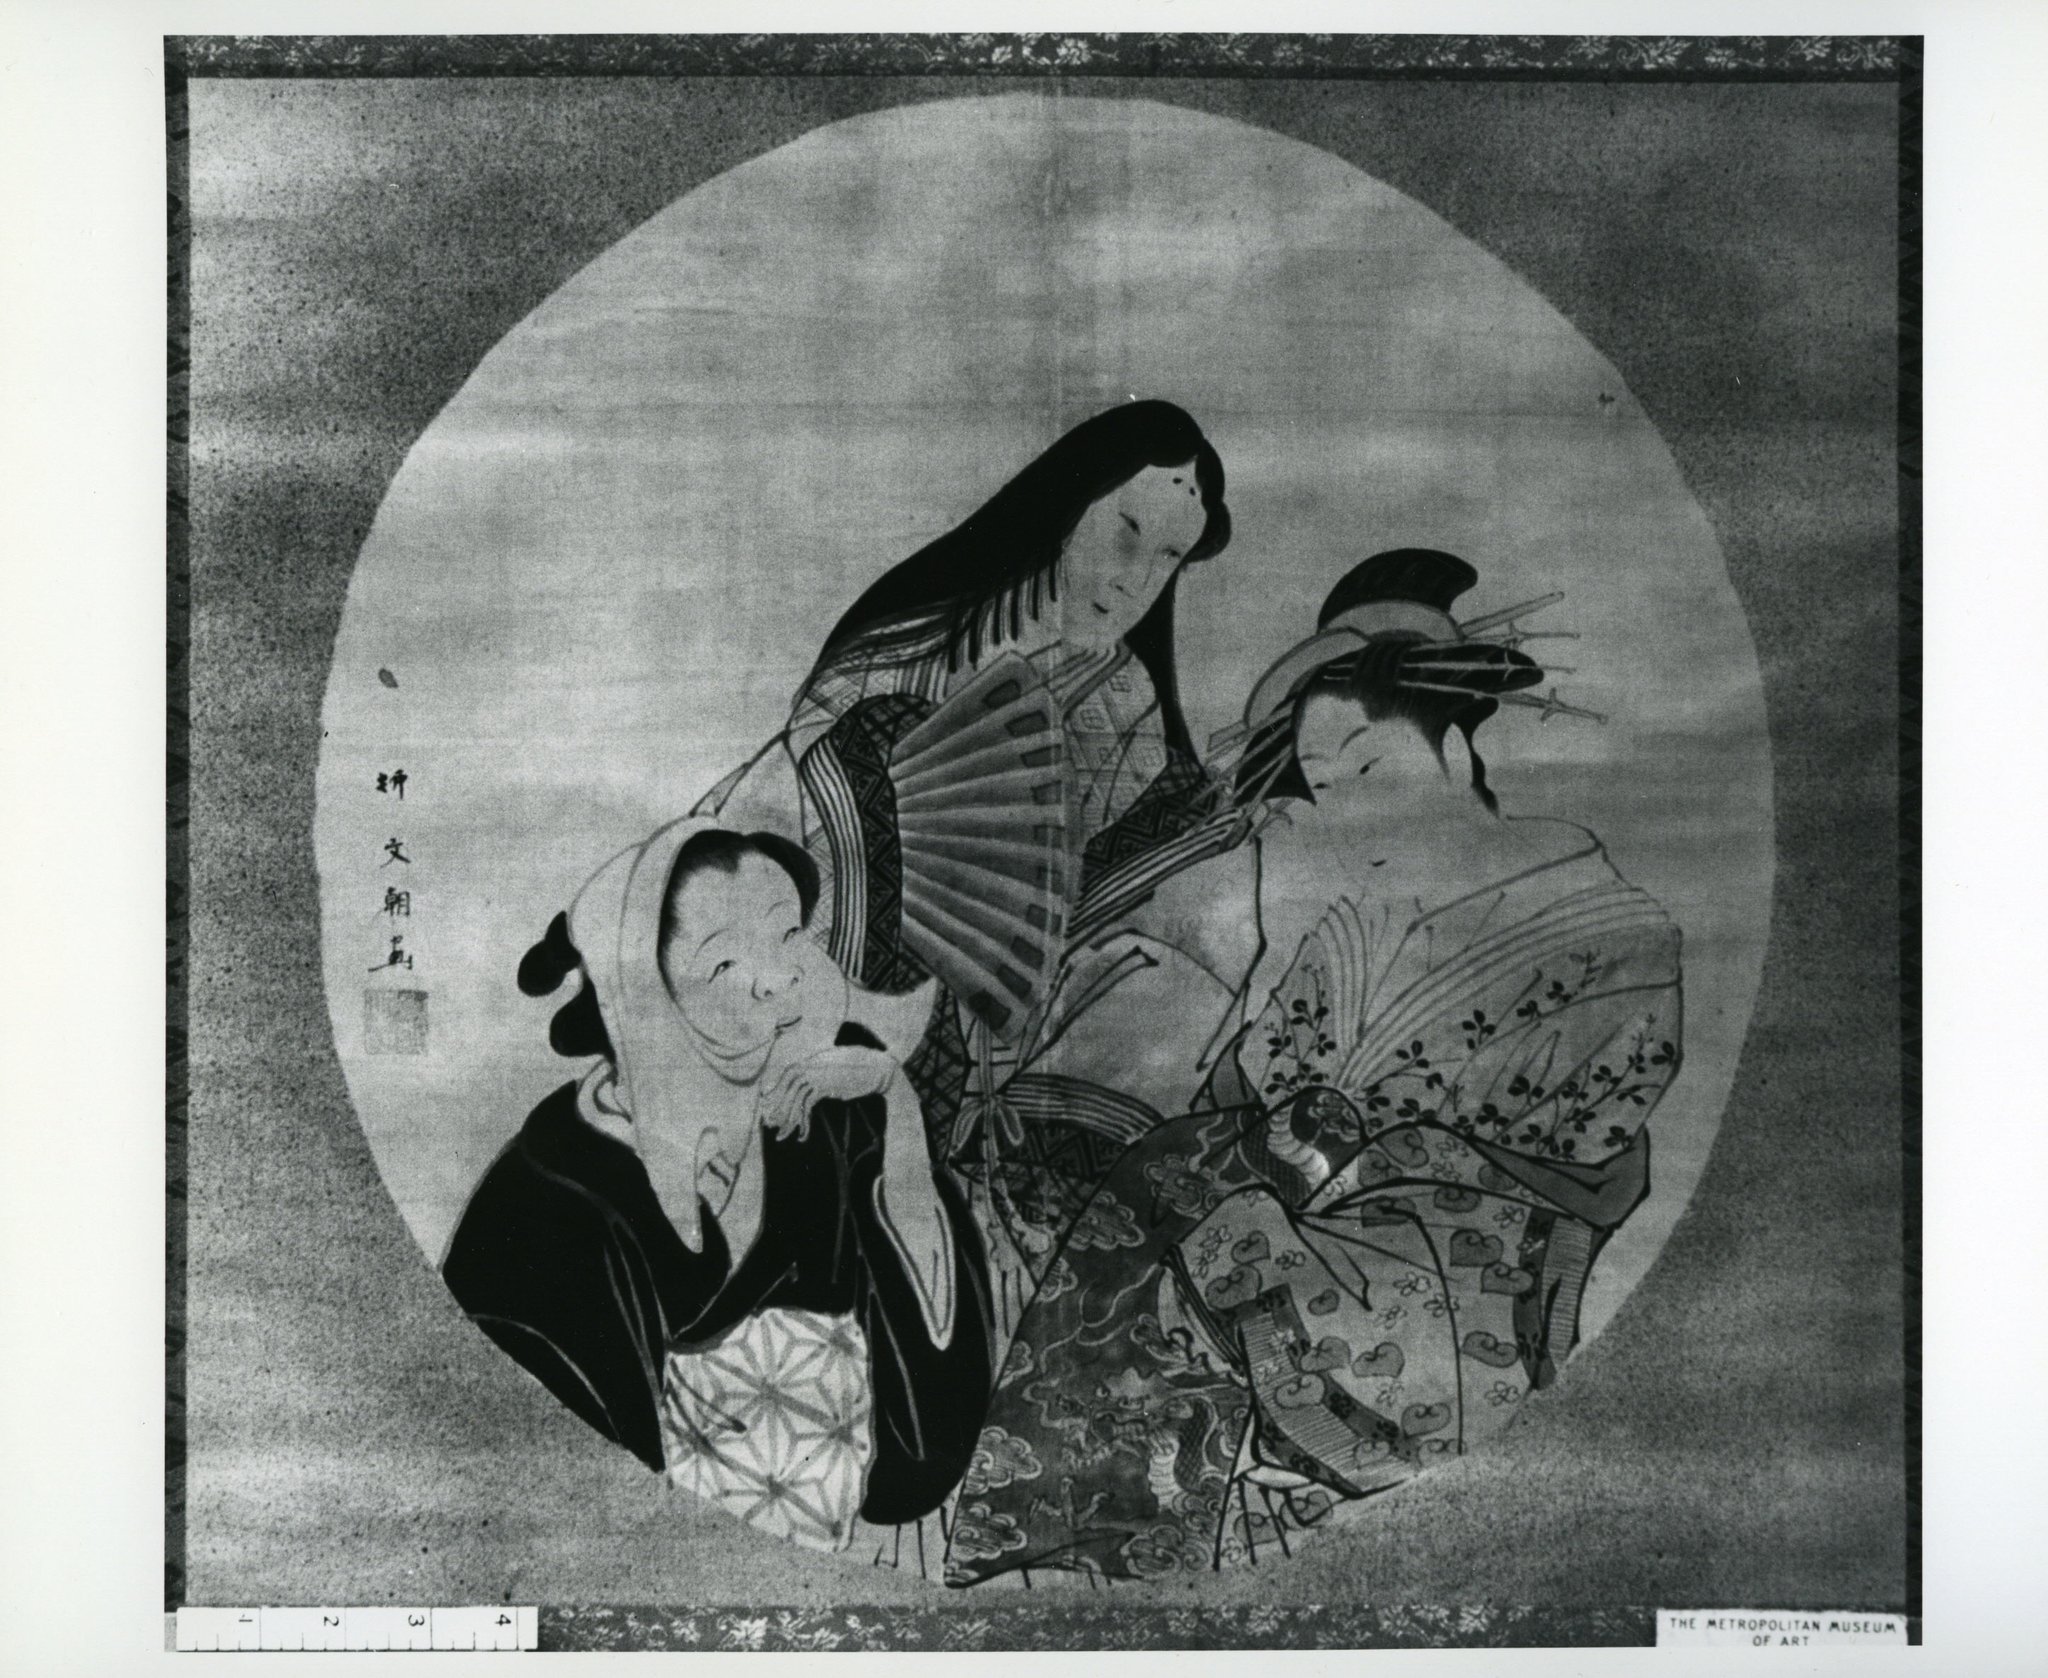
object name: hanging scroll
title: Beauties of the Three Classes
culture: japanese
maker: yanagi buncho ii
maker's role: artist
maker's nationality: japanese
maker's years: 1764-1801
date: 1701-1900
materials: ink, silk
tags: women